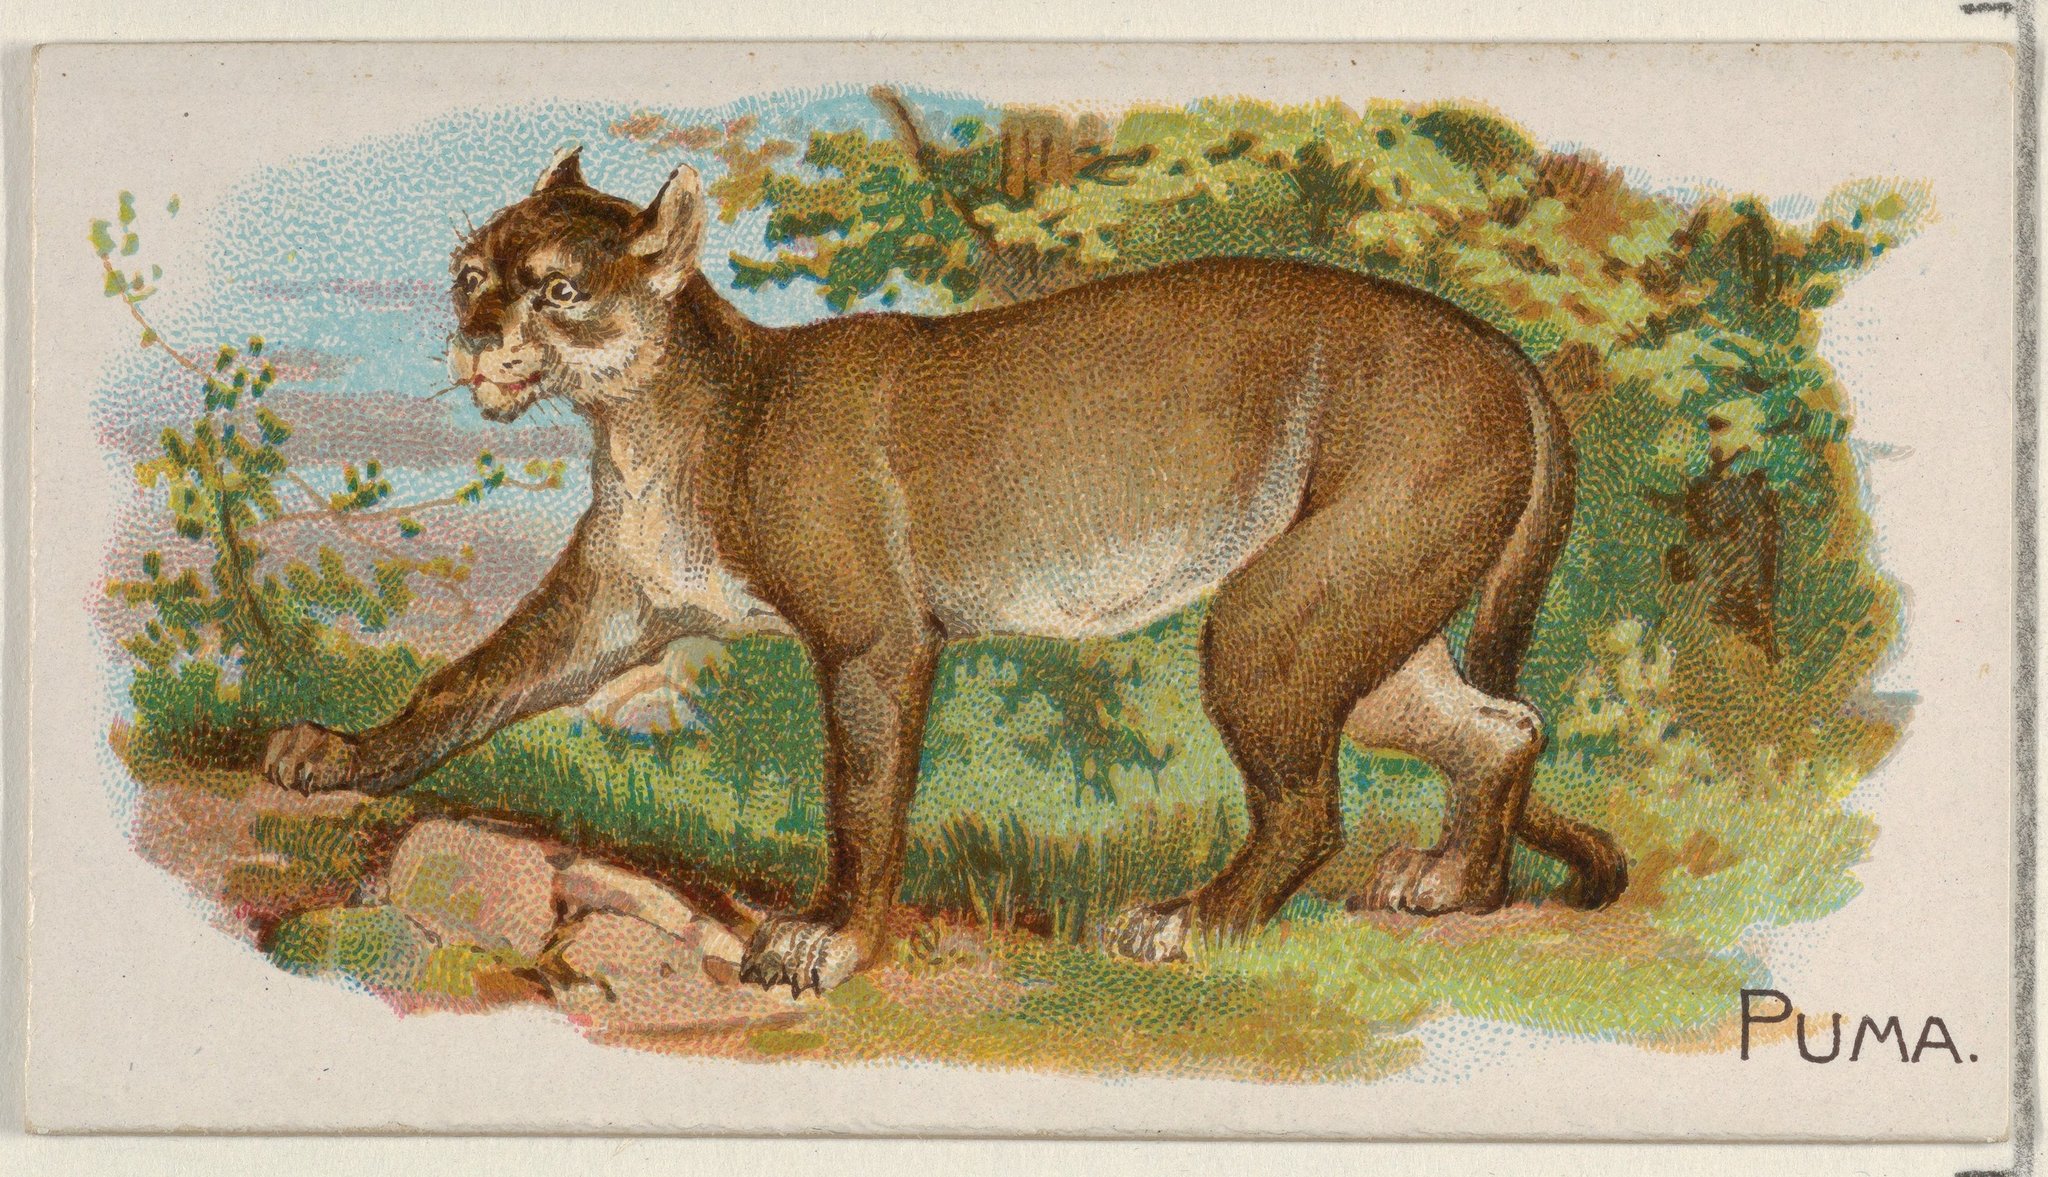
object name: print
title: Puma, from the Quadrupeds series (N21) for Allen & Ginter Cigarettes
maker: allen & ginter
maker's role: publisher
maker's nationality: american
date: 1890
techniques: color lithograph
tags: animals